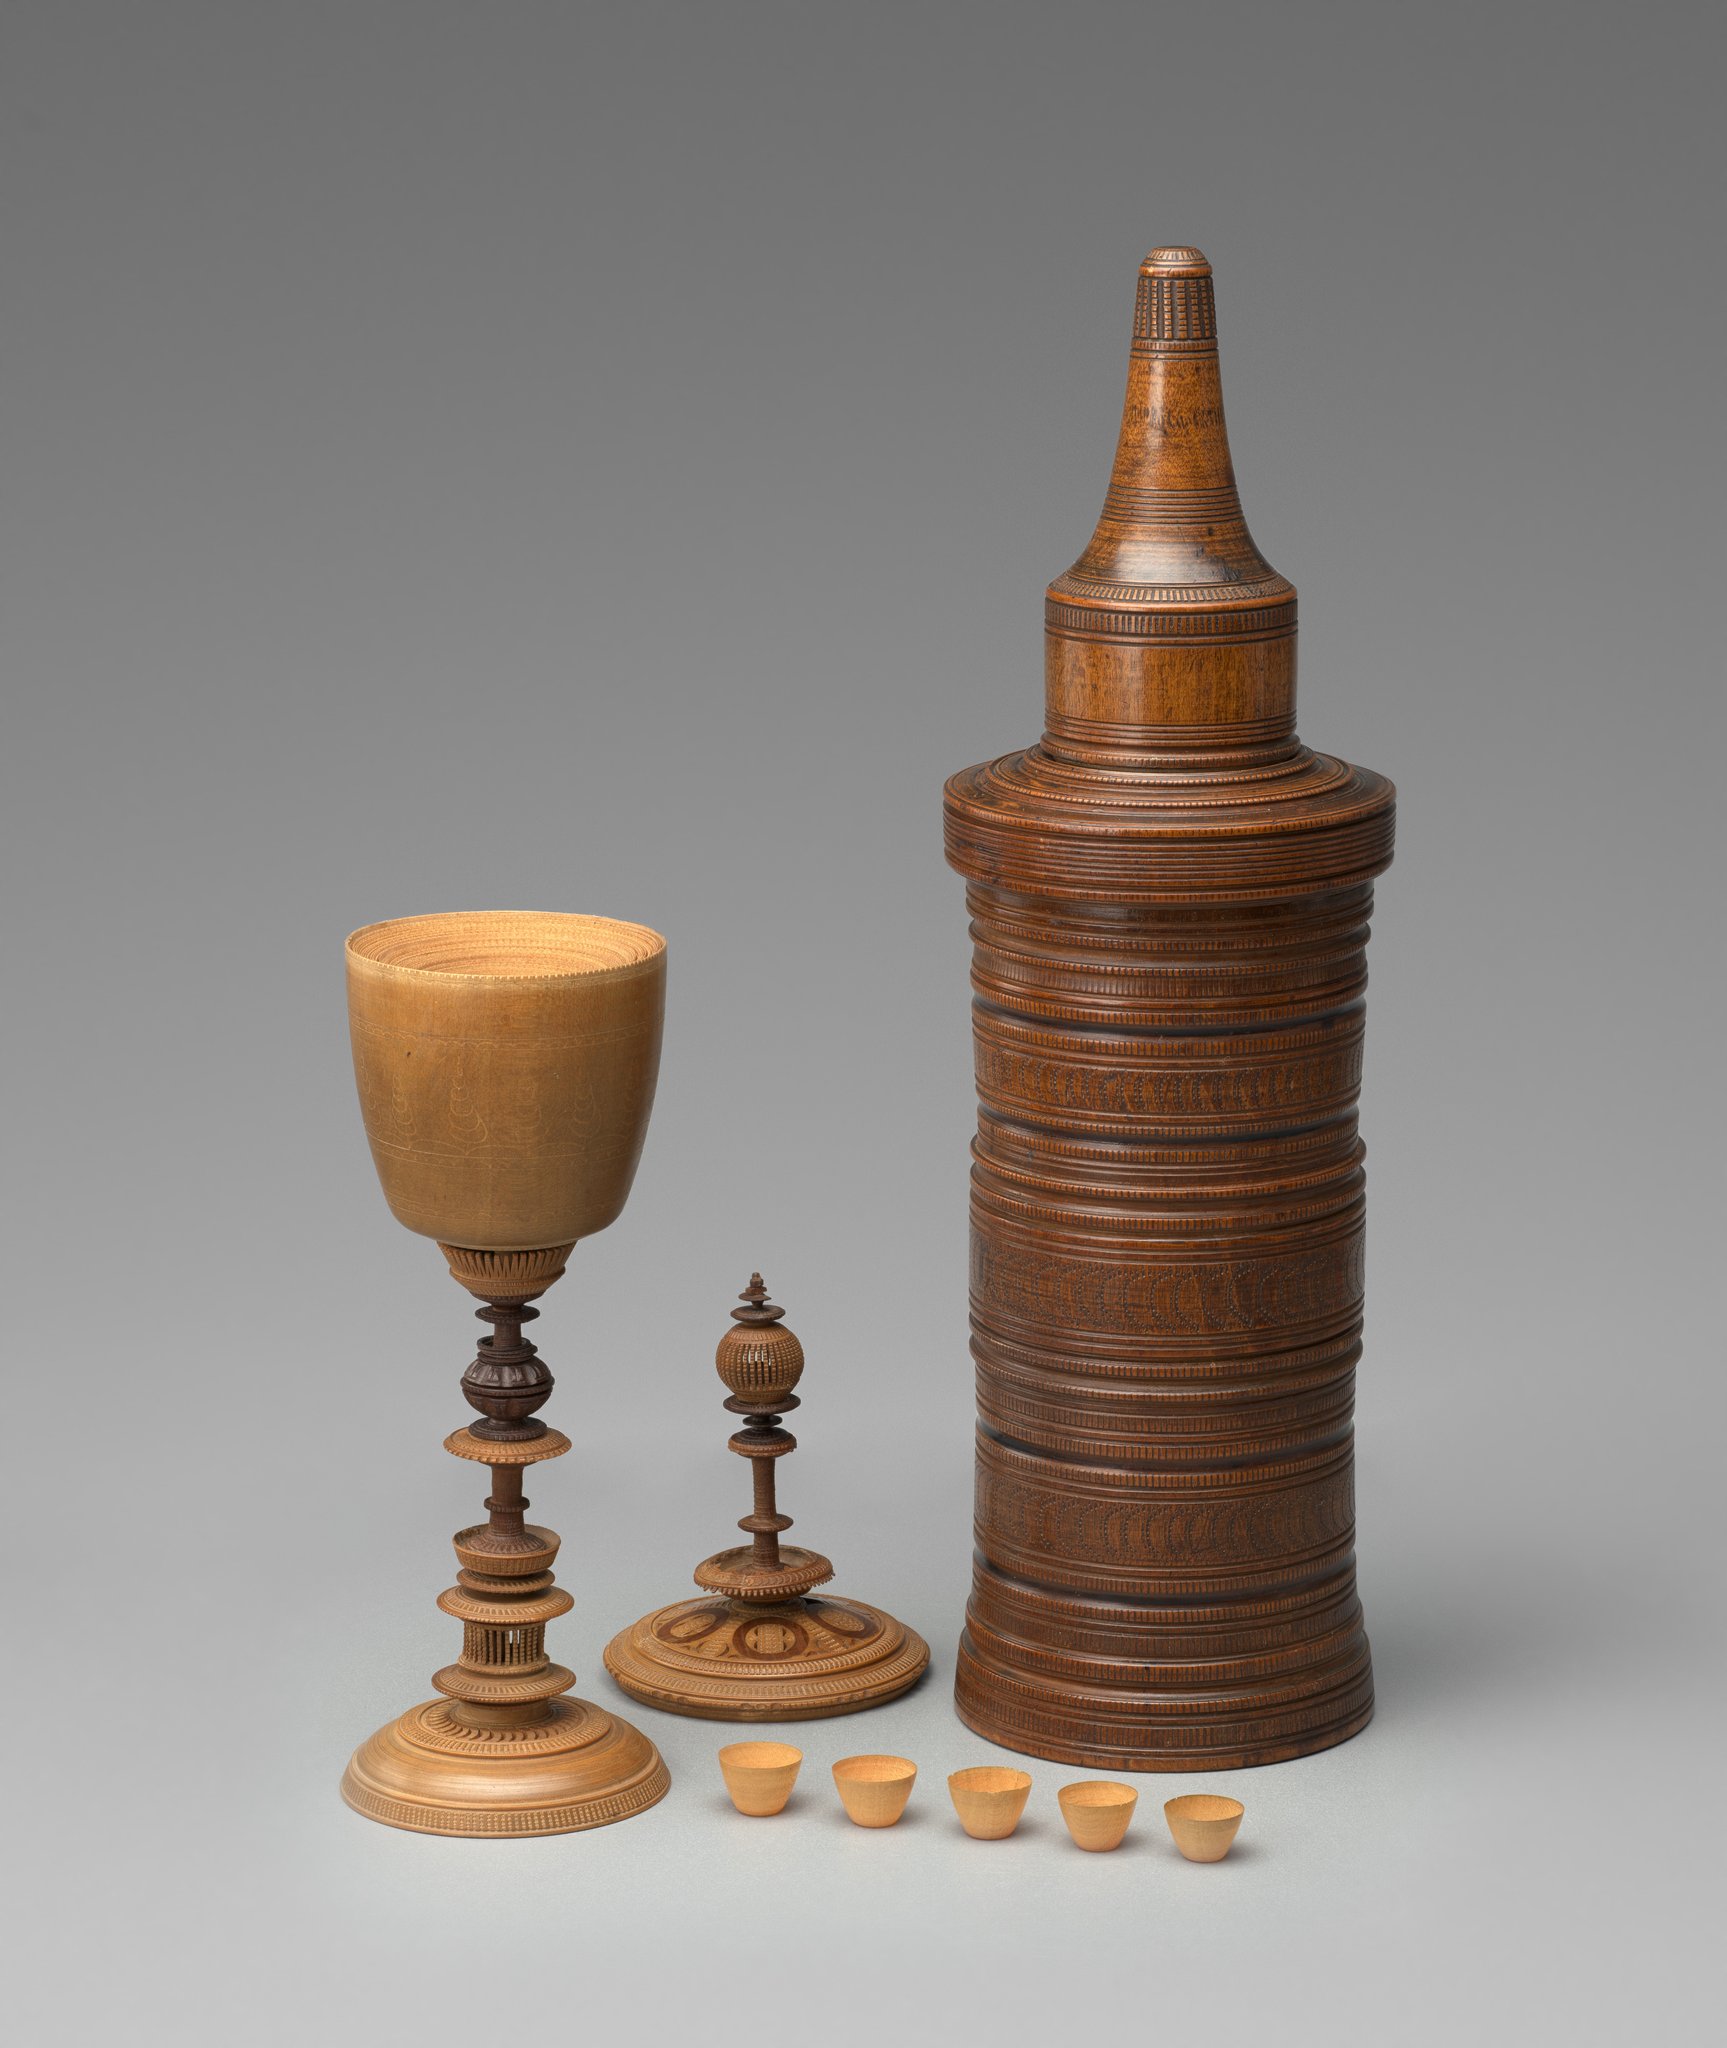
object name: cup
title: Turned cup and cover with inserts and original case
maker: unidentified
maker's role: maker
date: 1620-1650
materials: wood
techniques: carving, stain